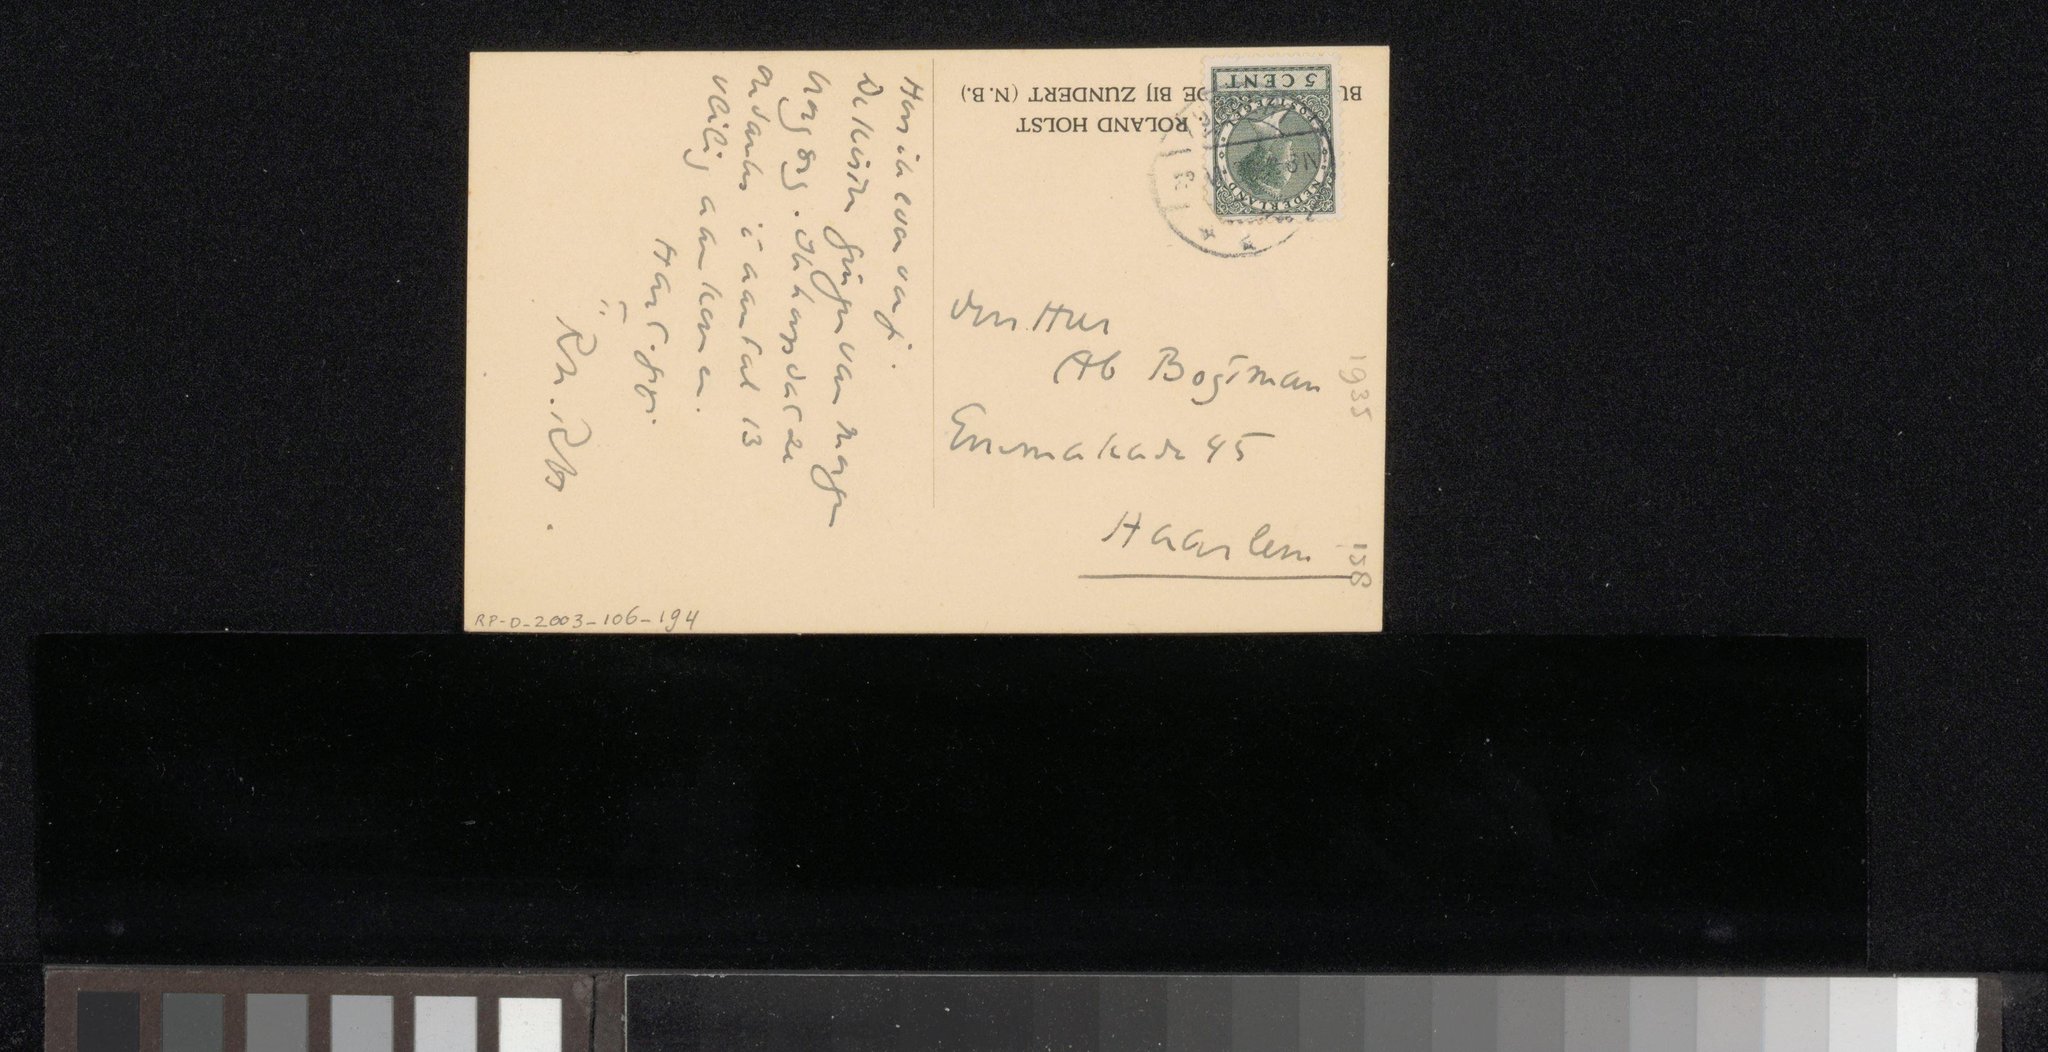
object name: postcard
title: Briefkaart aan Ab Bogtman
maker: richard nicolaüs roland holst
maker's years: 1868-1938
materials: cardboard, ink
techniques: pen, printing, writing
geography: buissche heide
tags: ab bogtman, toos bogtman, haarlem, willem bogtman, applied arts, arts and crafts; industrial design, brussels